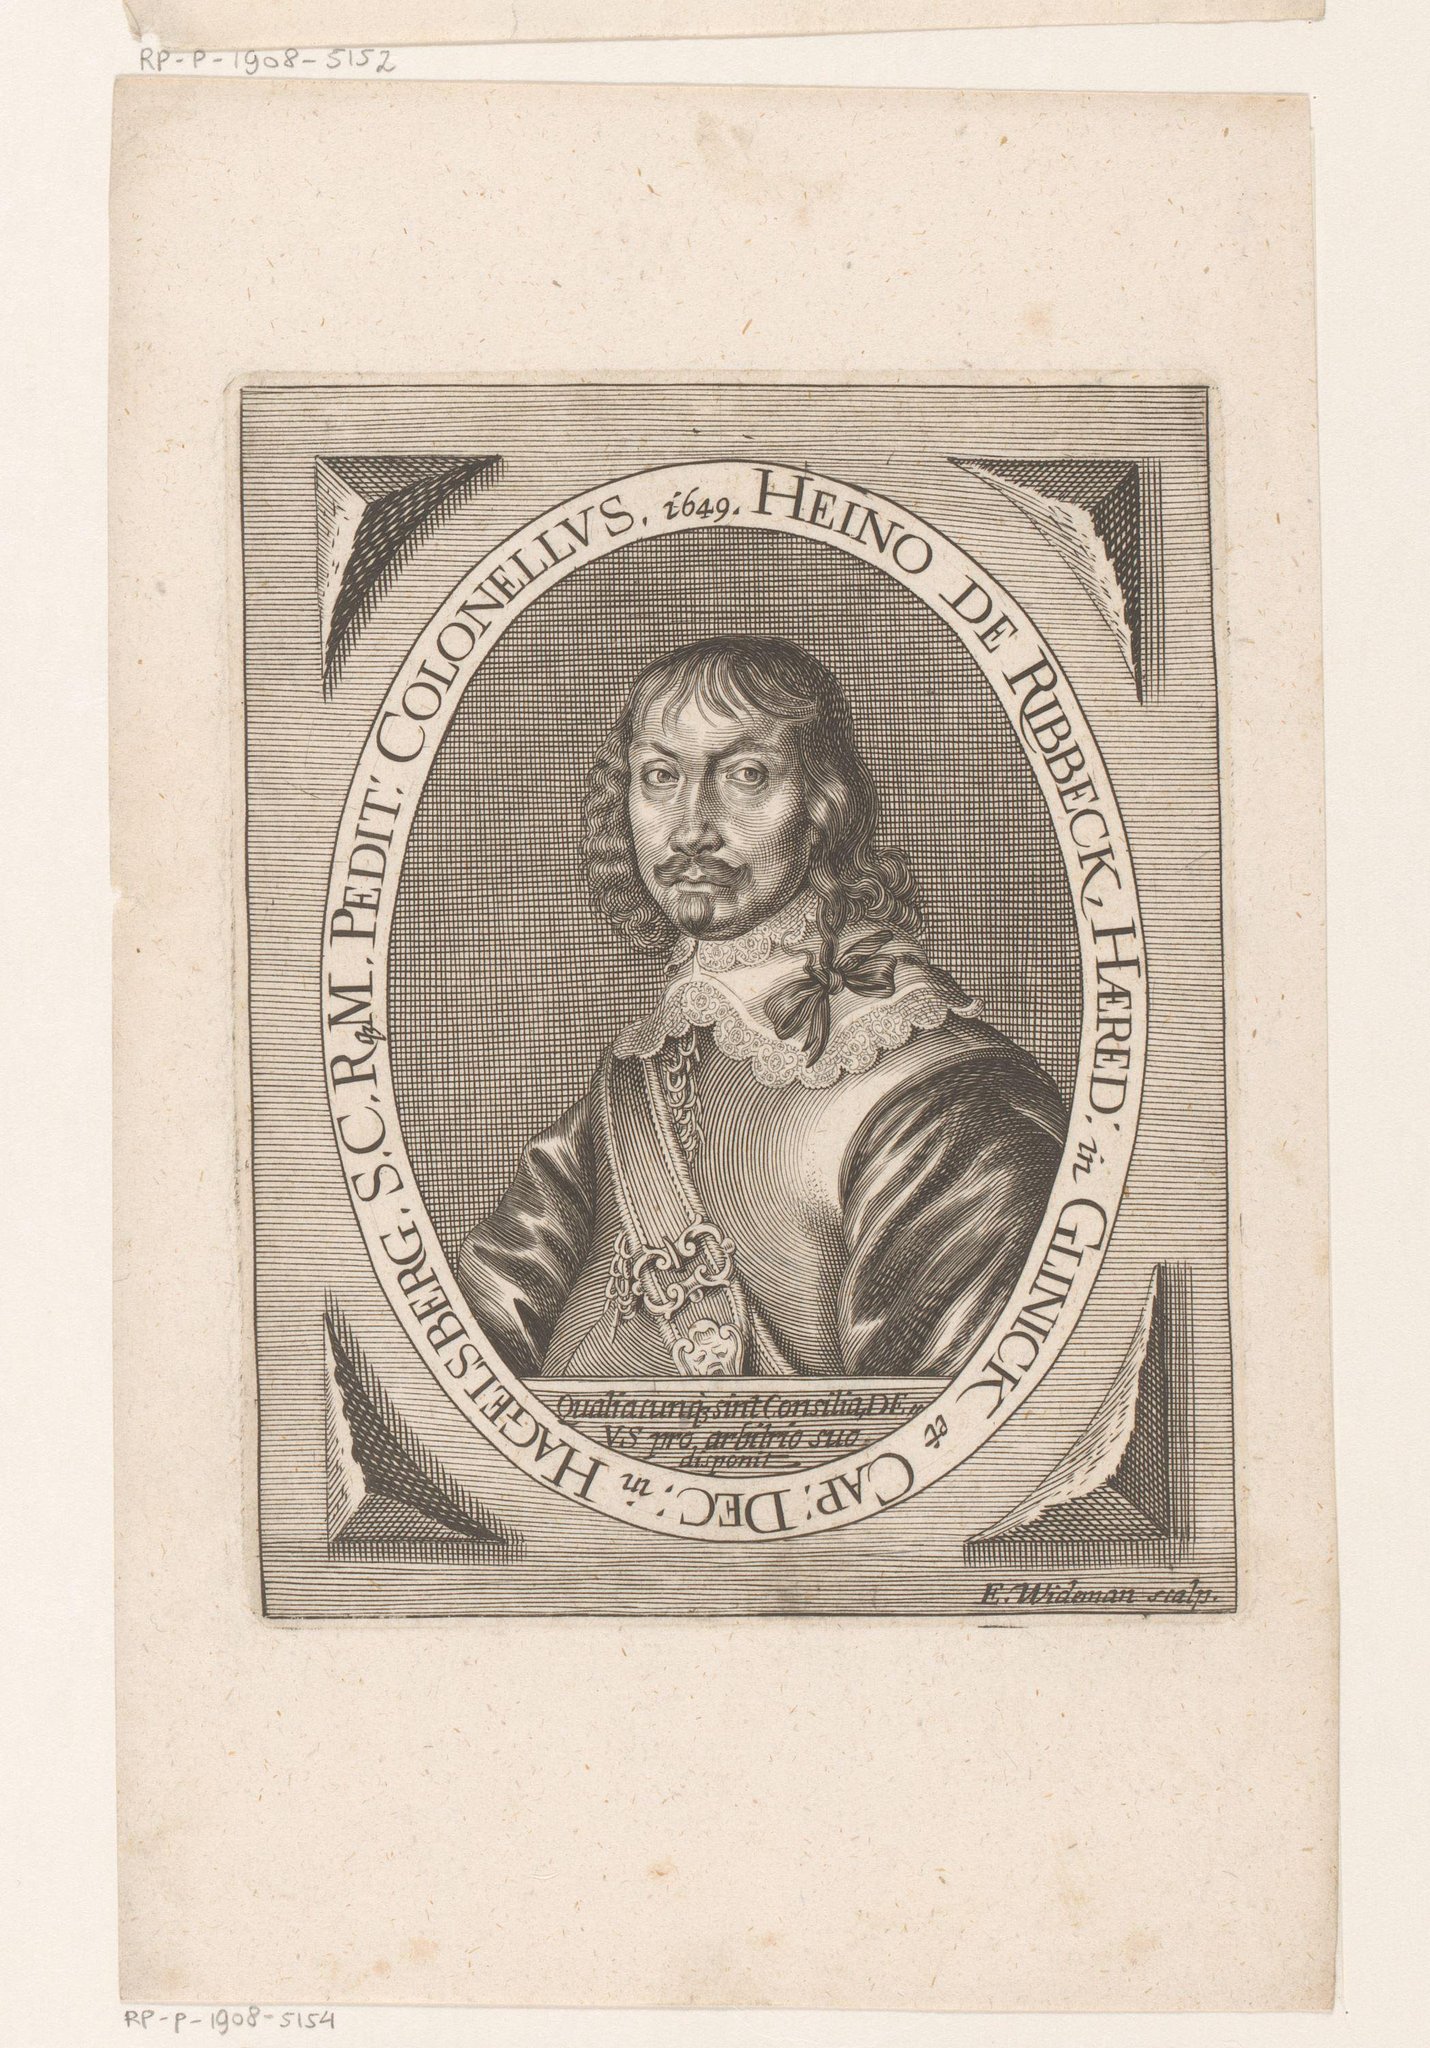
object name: print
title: Portret van Heino von Ribbeck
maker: elias widemann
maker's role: print maker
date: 1649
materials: paper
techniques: engraving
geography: vienna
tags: historical persons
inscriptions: collector's mark: Lugt 2228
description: Prent uit de publicatie: Widemann, Elias. Honori Sacrum. Wenen: s.n., 1649.